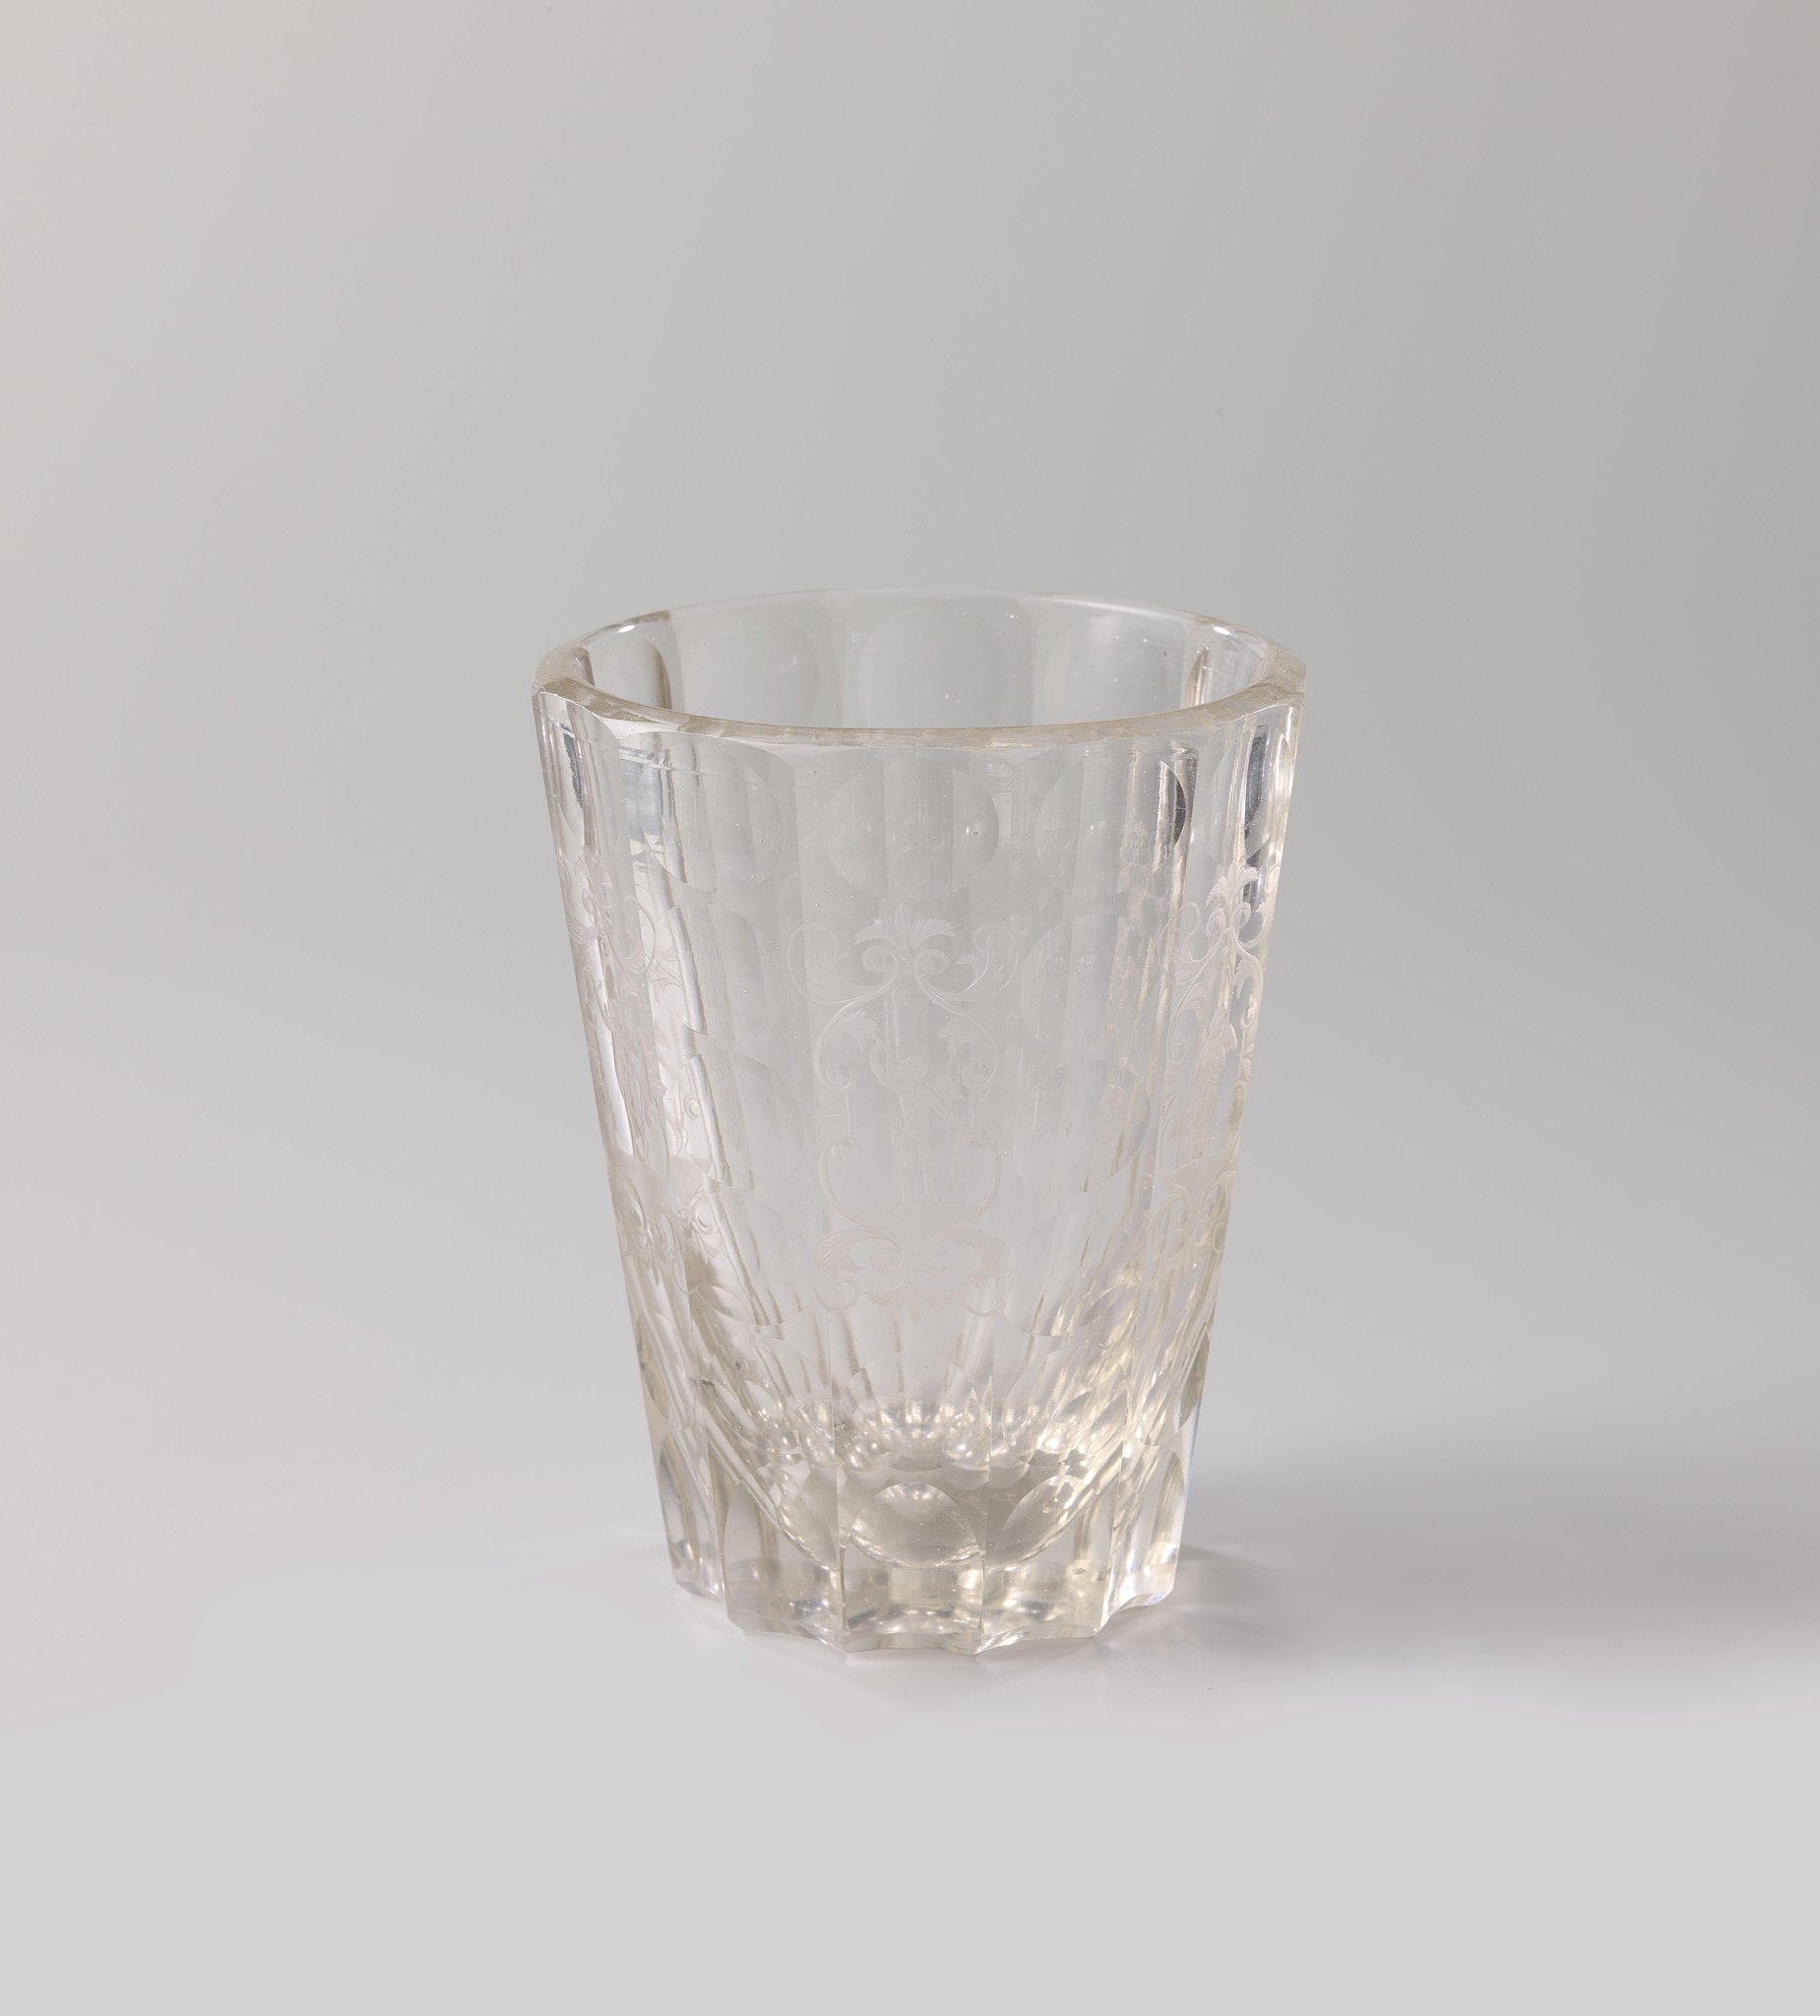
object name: cup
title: Beker met cartouches met amors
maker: Anonymous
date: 1725-1750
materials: crystal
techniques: glassblowing, grinding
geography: bohemia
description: Beker van helder, kleruloos glas. De veelvlakkige kelk vertoont beurtelings om de andere facet een amor binnen een cartouche.